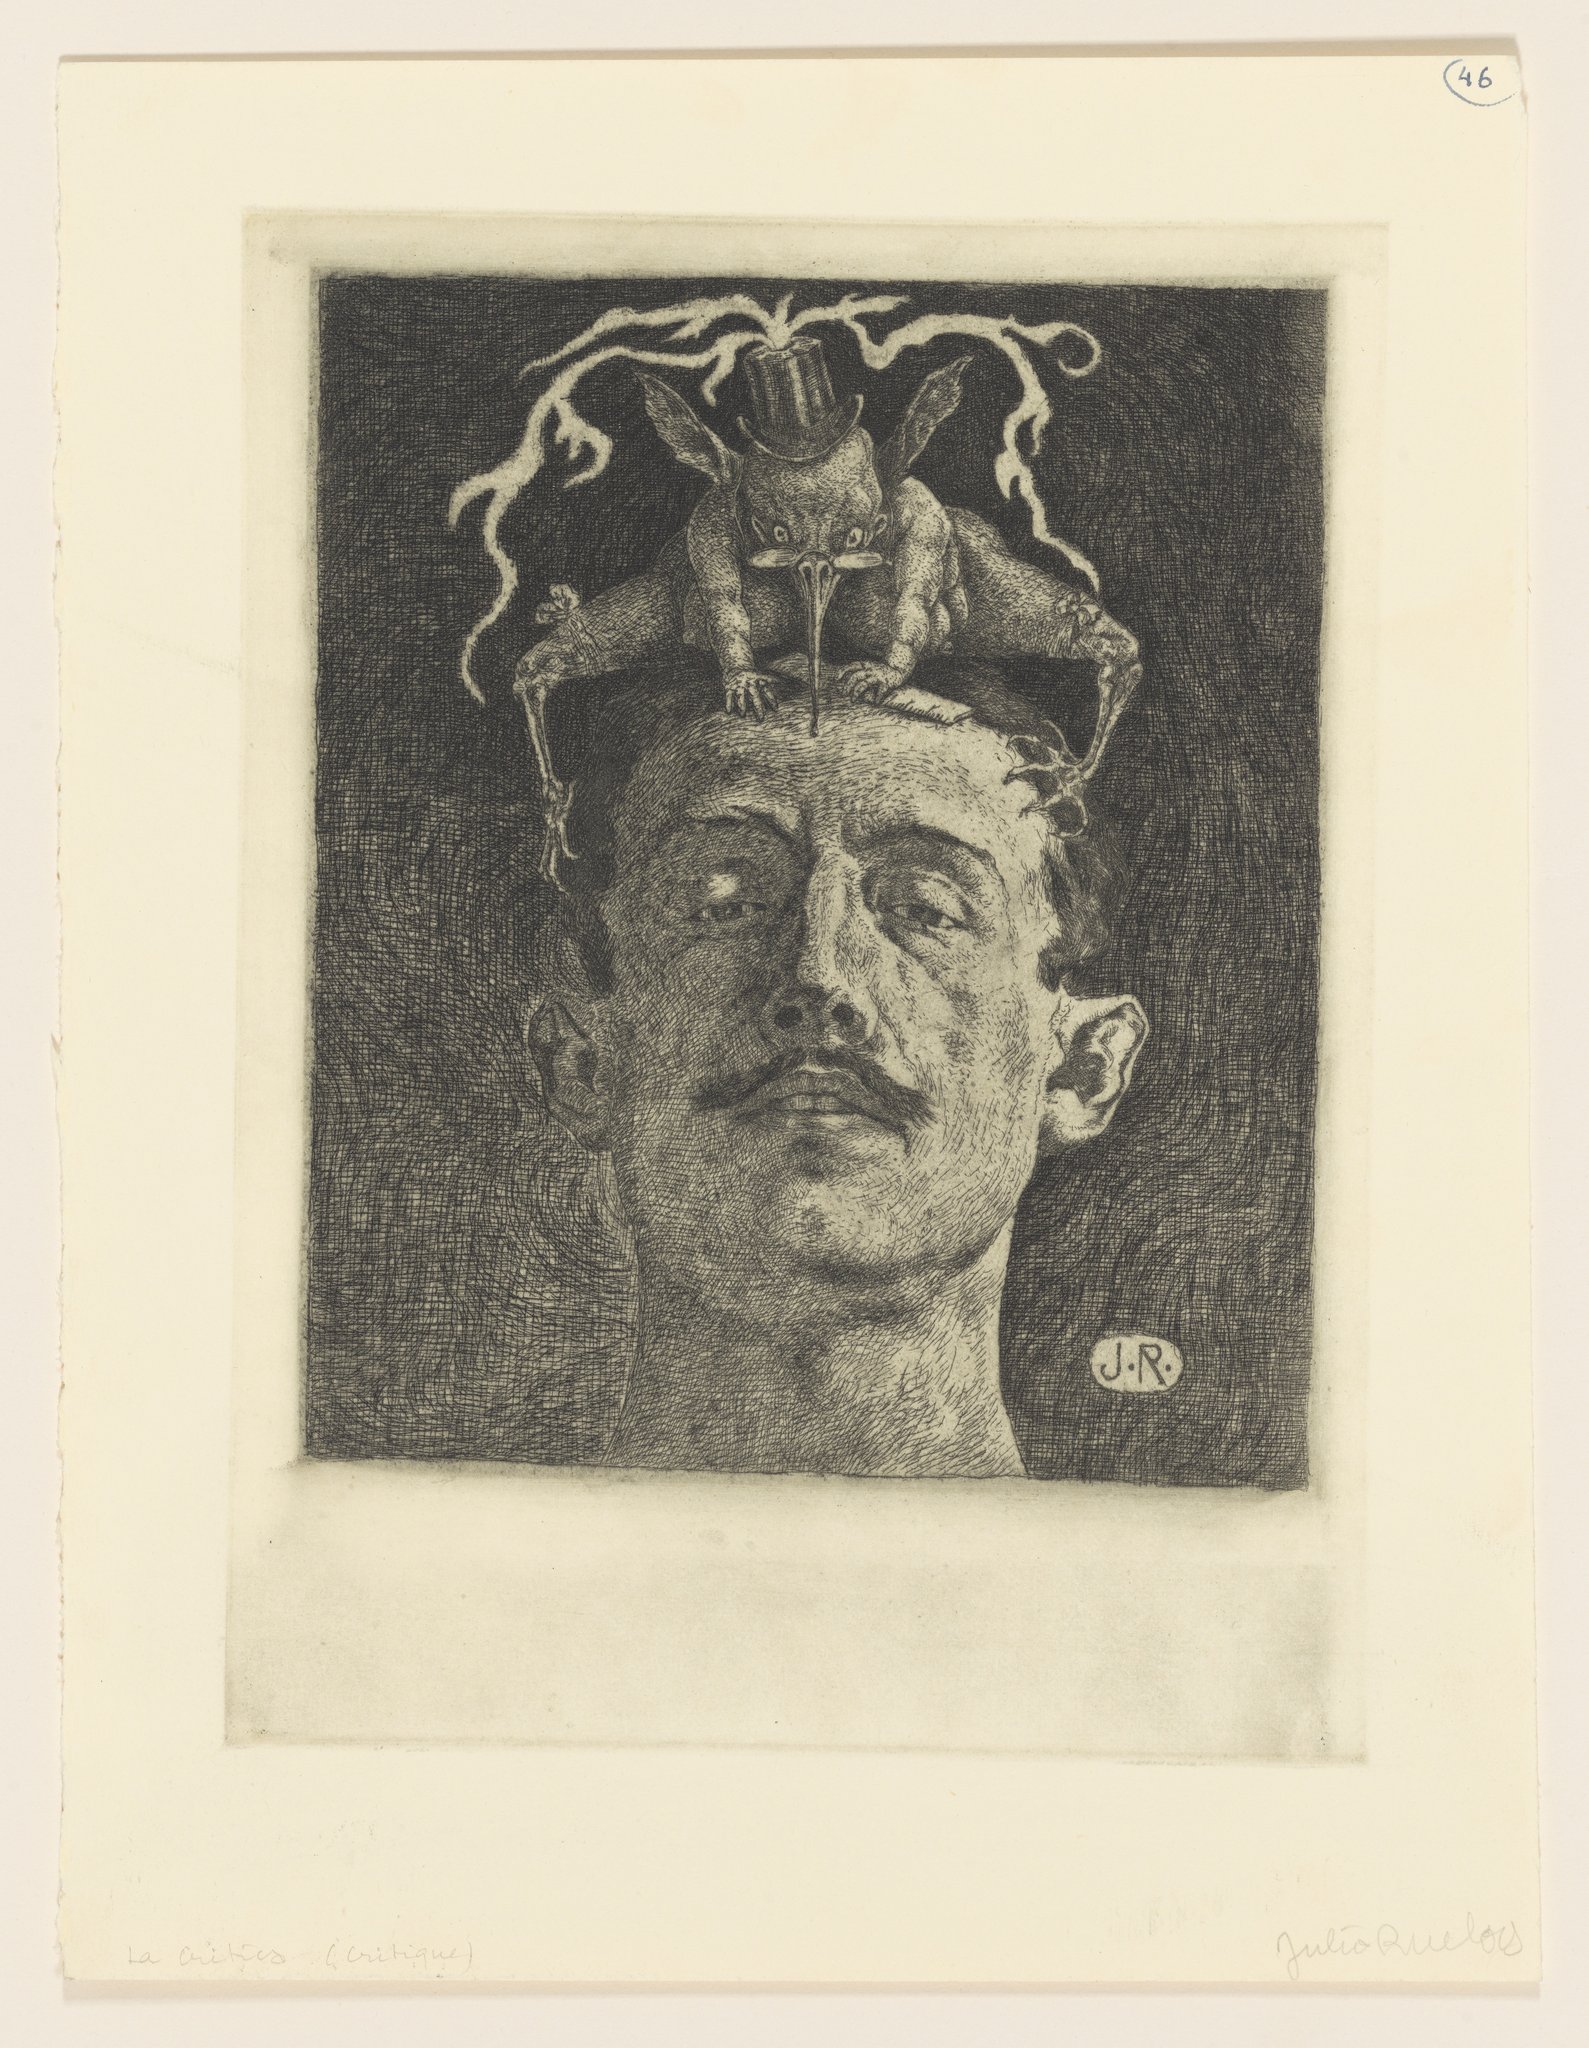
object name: print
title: The Critic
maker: julio ruelas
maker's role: artist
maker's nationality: mexican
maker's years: 1870-1907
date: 1905-1907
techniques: etching